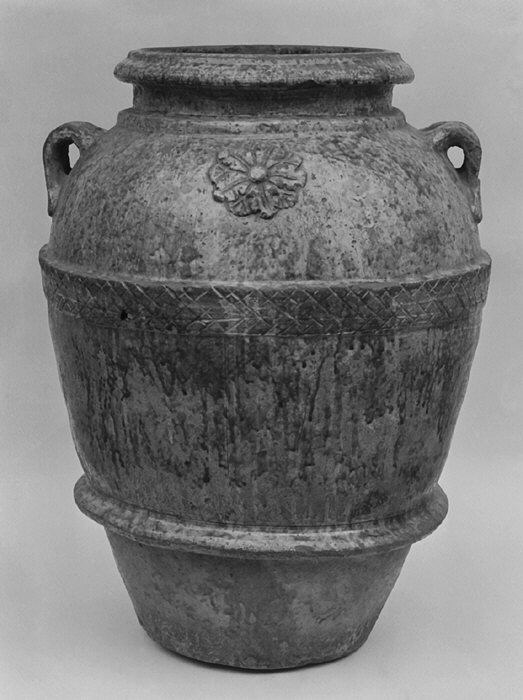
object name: jar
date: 1734-1766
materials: earthenware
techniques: glazing